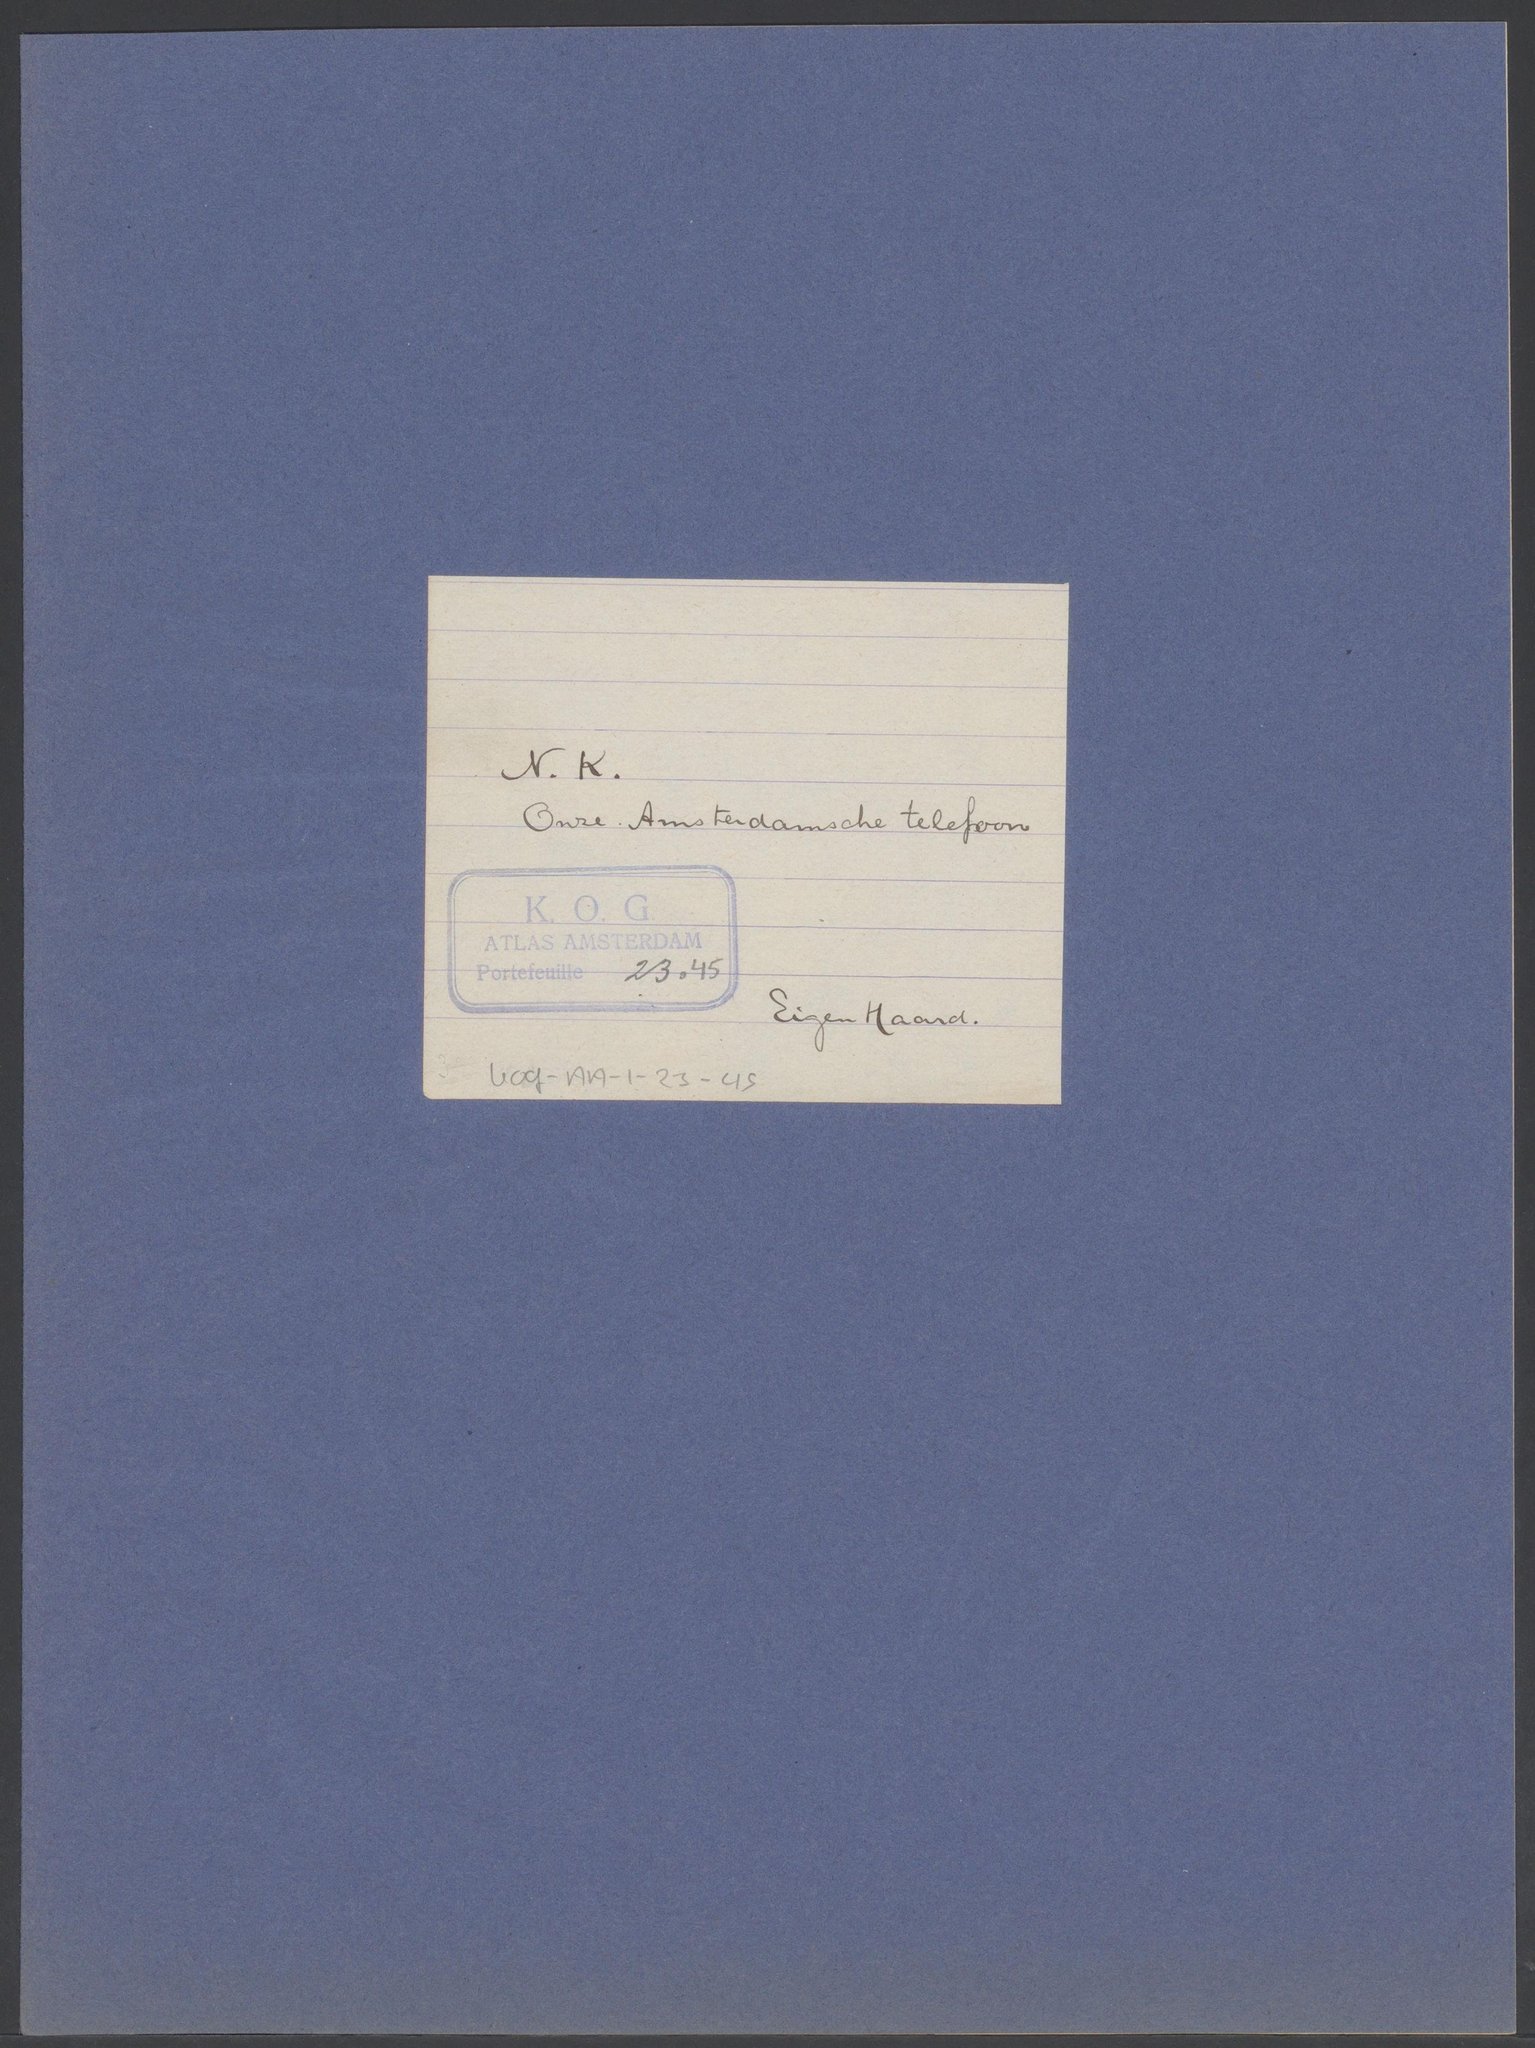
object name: article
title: Artikel over het proces achter telefoneren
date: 1906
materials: paper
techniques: letterpress printing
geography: amsterdam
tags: (other) telephone equipment, amsterdam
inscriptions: collector's mark: Lugt 1641b, signature: ‘N.K.’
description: Object bestaat uit twee pagina's in een omslag. Onderwerpsrubriek binnen de Atlas Amsterdam: Gemeentebedrijven.